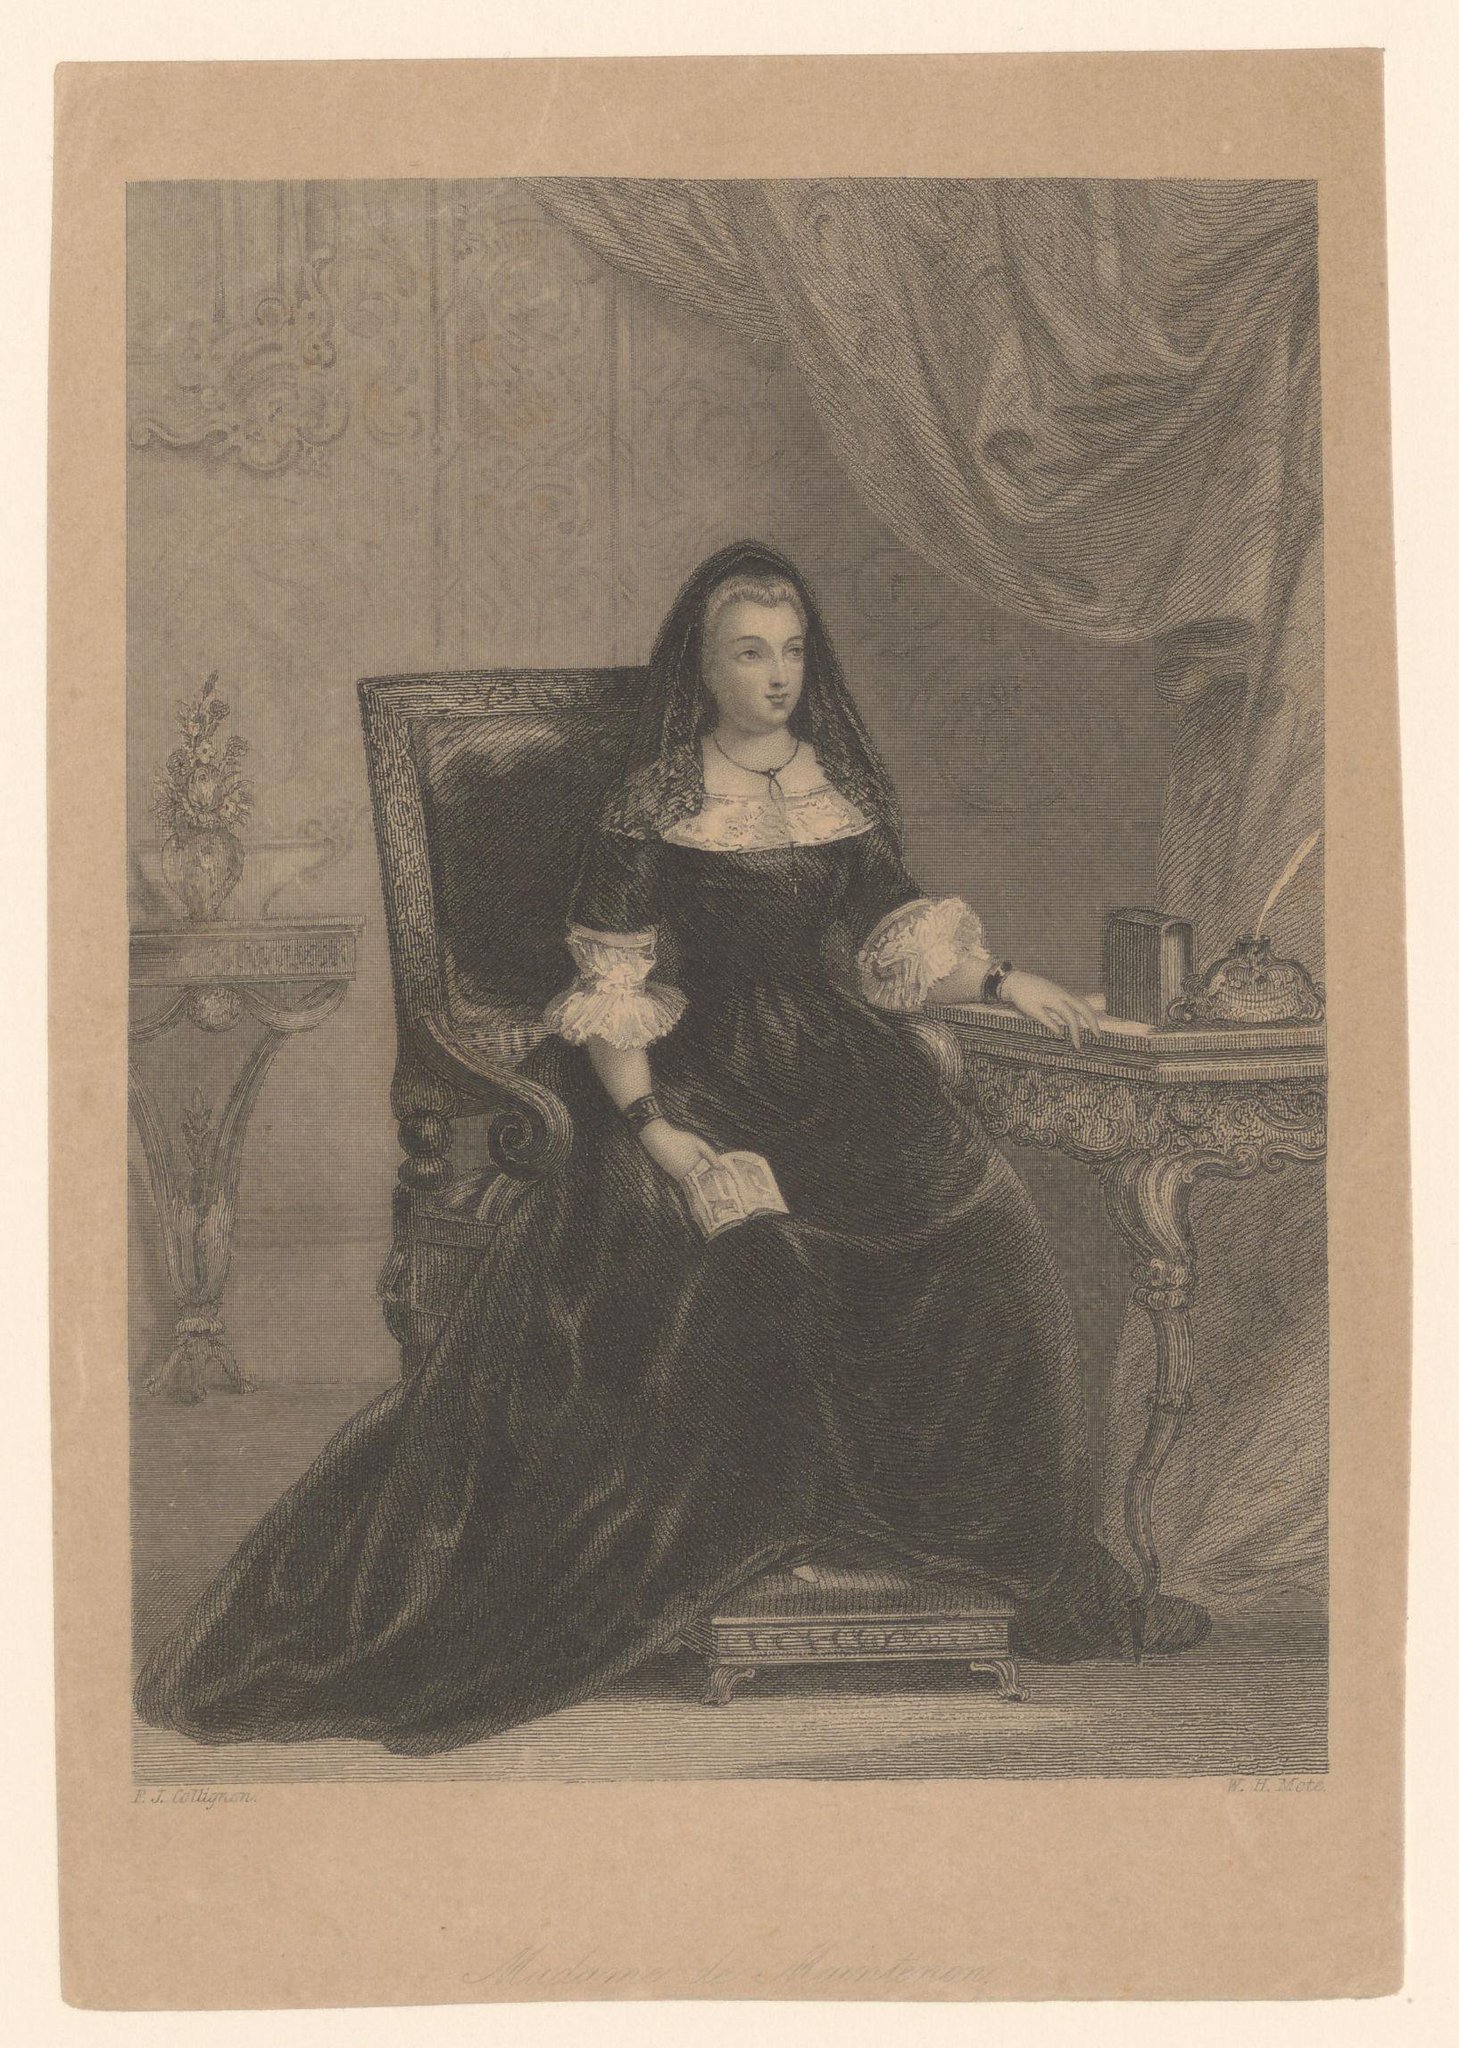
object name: print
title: Madame de Maintenon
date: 1813-1871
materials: paper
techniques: etching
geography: england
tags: madame de maintenon, historical persons - bb - woman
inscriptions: collector's mark: Lugt 2228